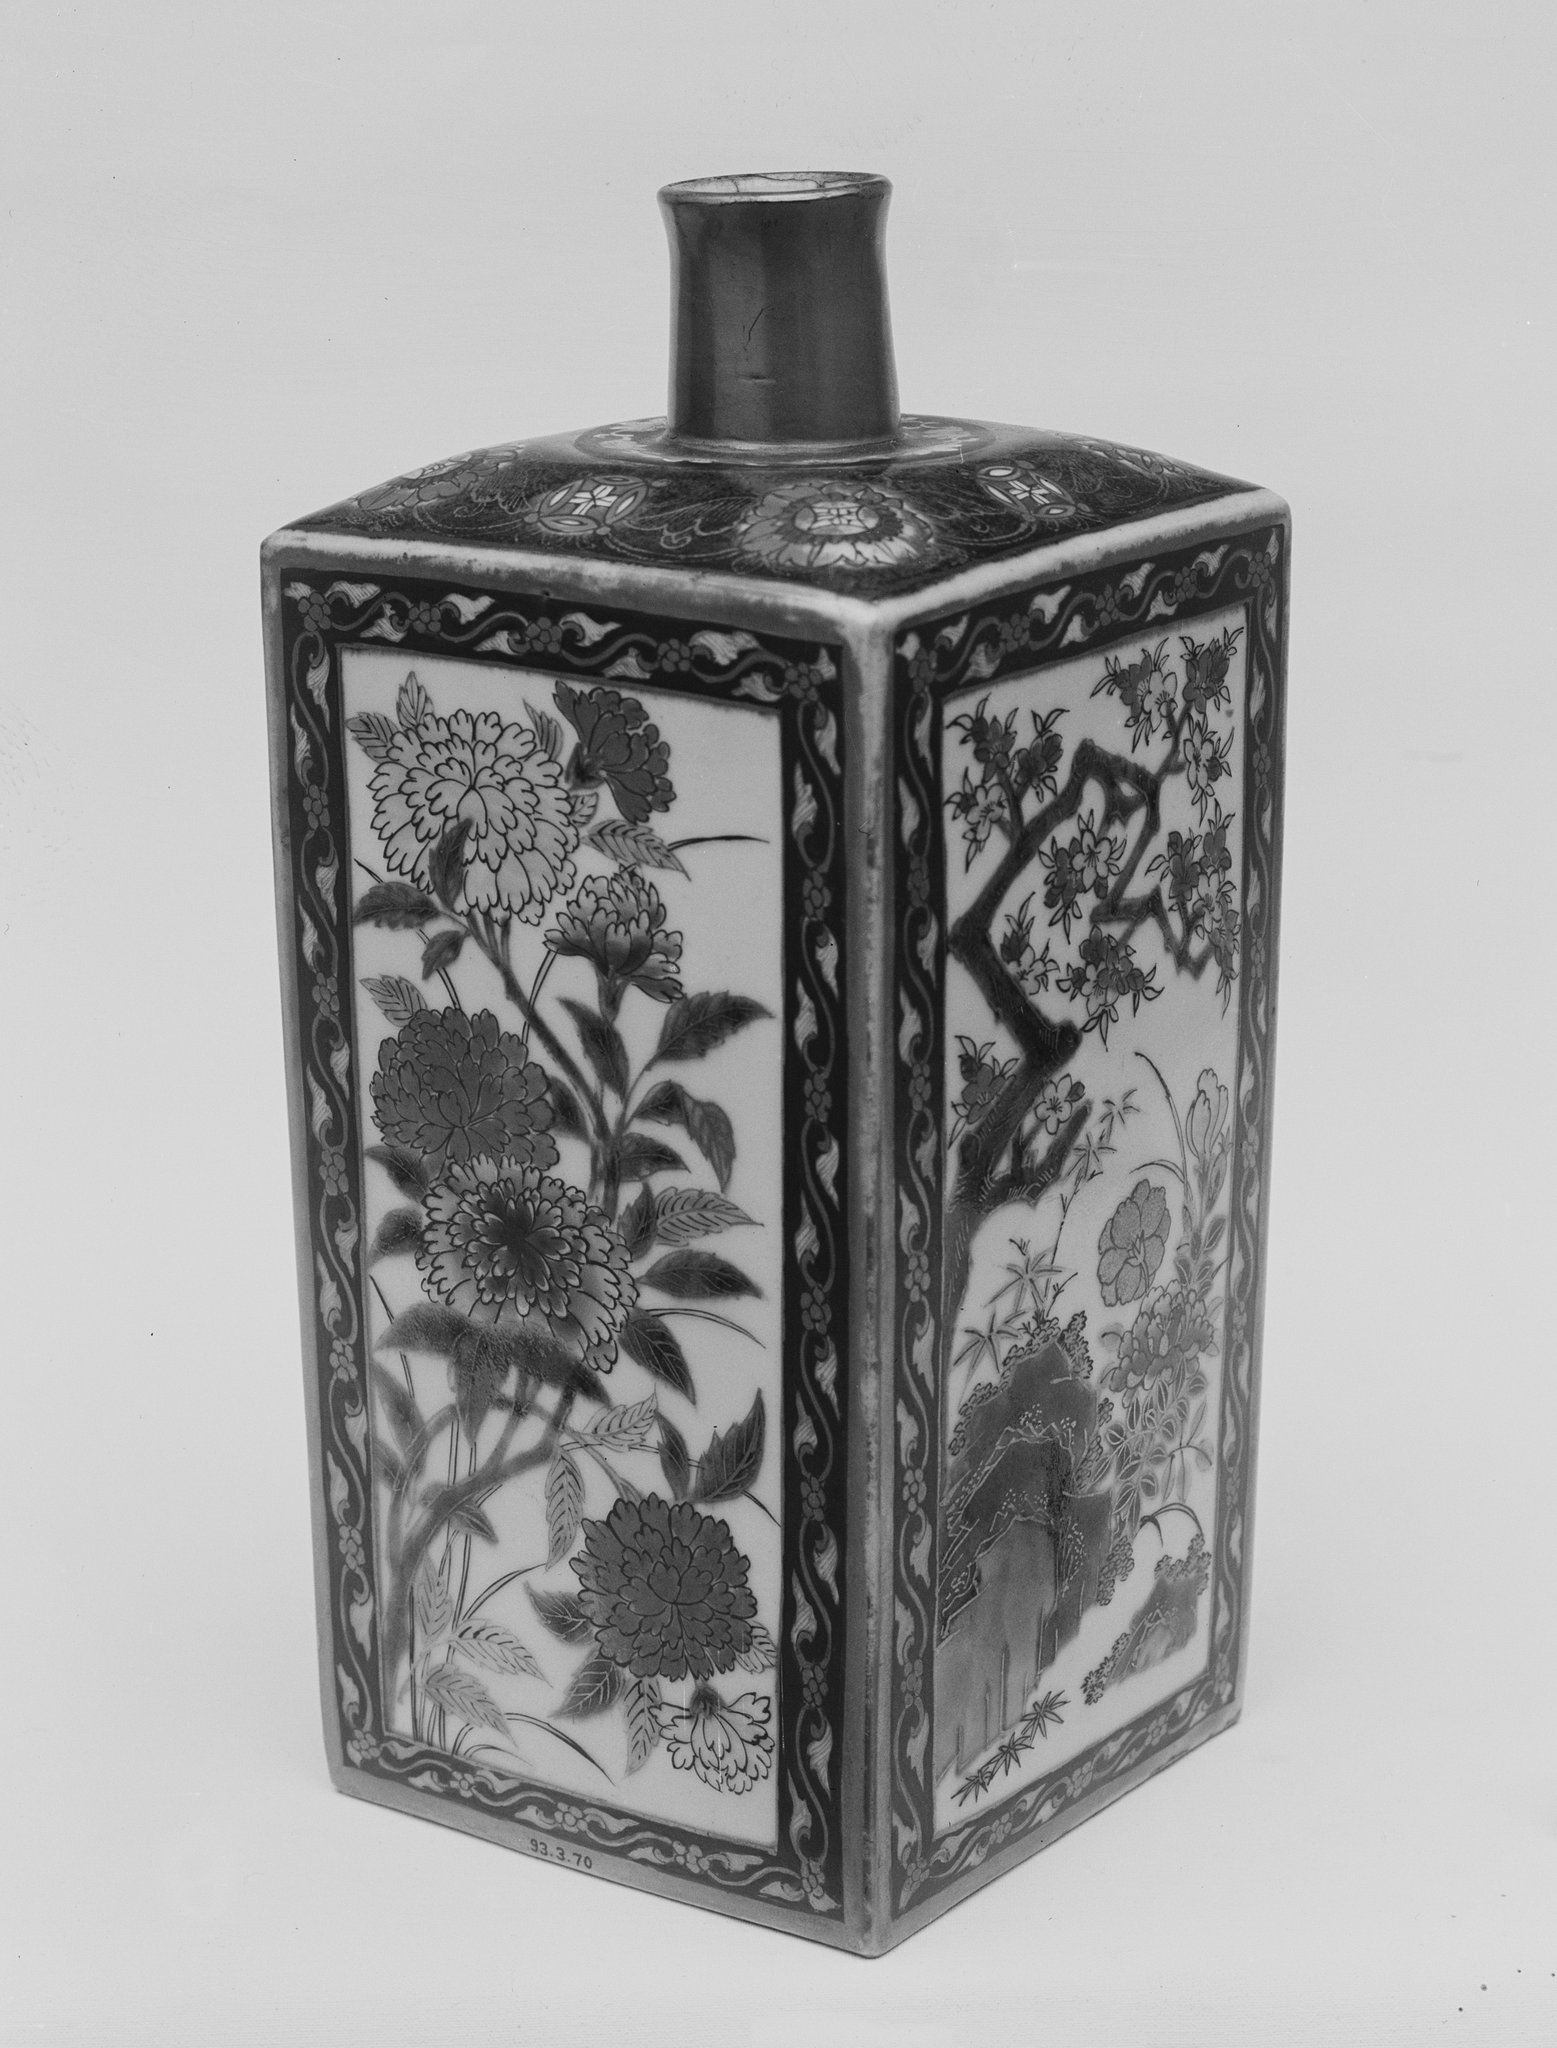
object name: bottle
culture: japanese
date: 1750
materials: enamel, glaze, porcelain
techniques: polychrome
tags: flowers